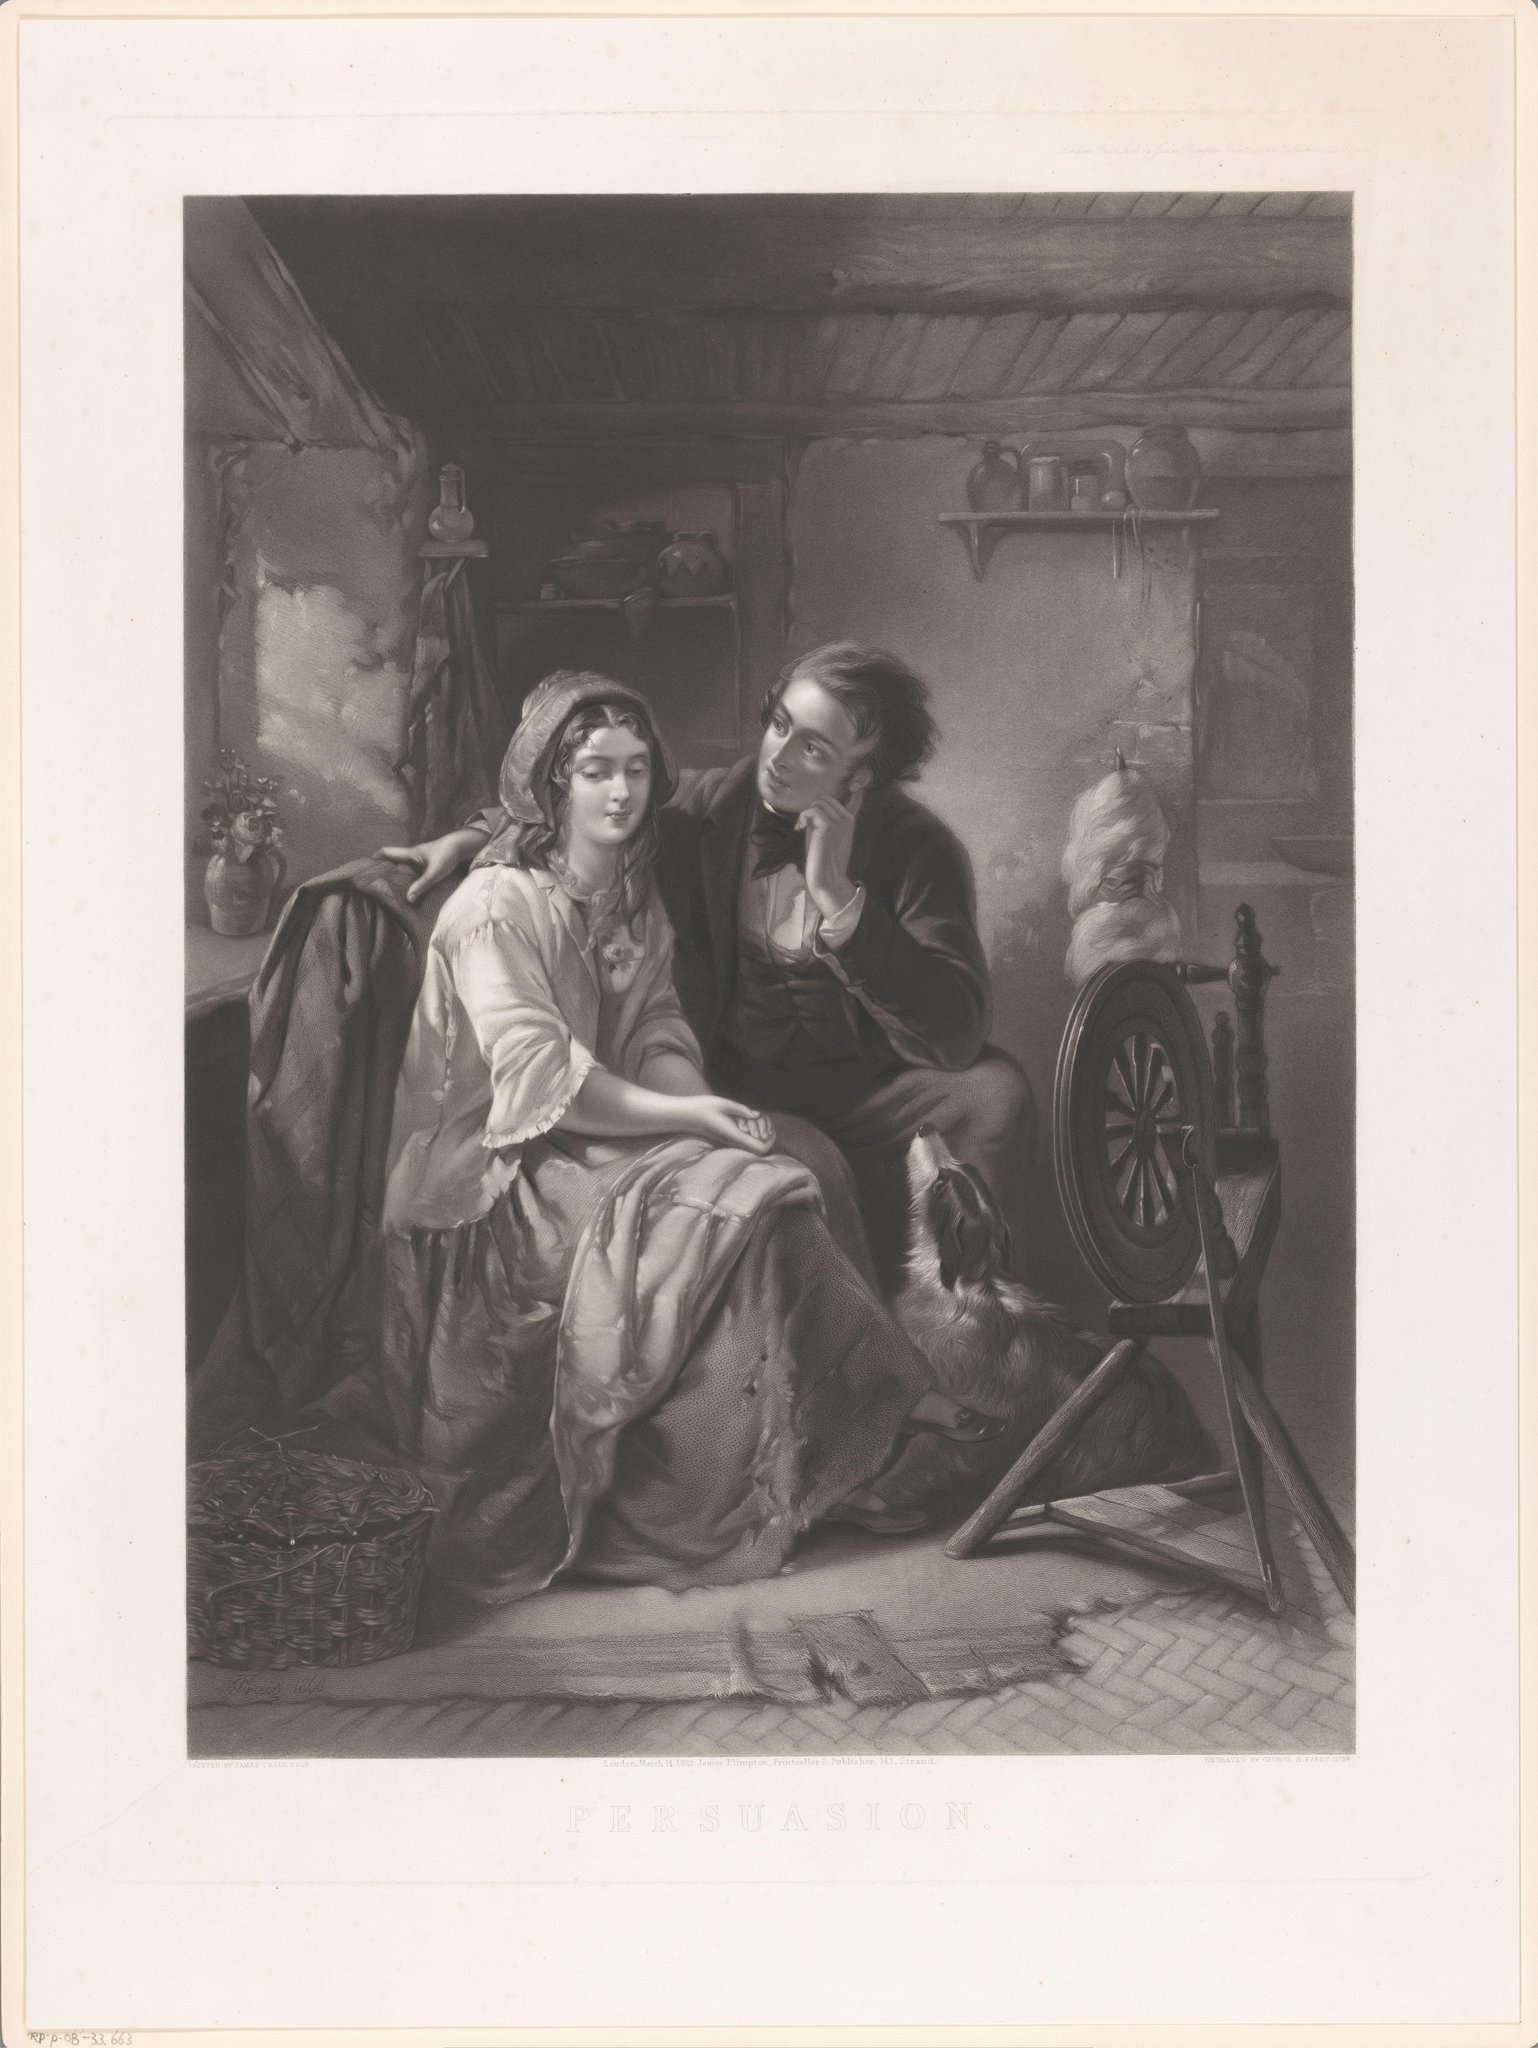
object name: print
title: Man probeert een vrouw te verleiden die aan een weefgetouw zit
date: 1860-1862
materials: paper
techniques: etching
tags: spinning-wheel, persuasion; 'persuasione' (ripa)